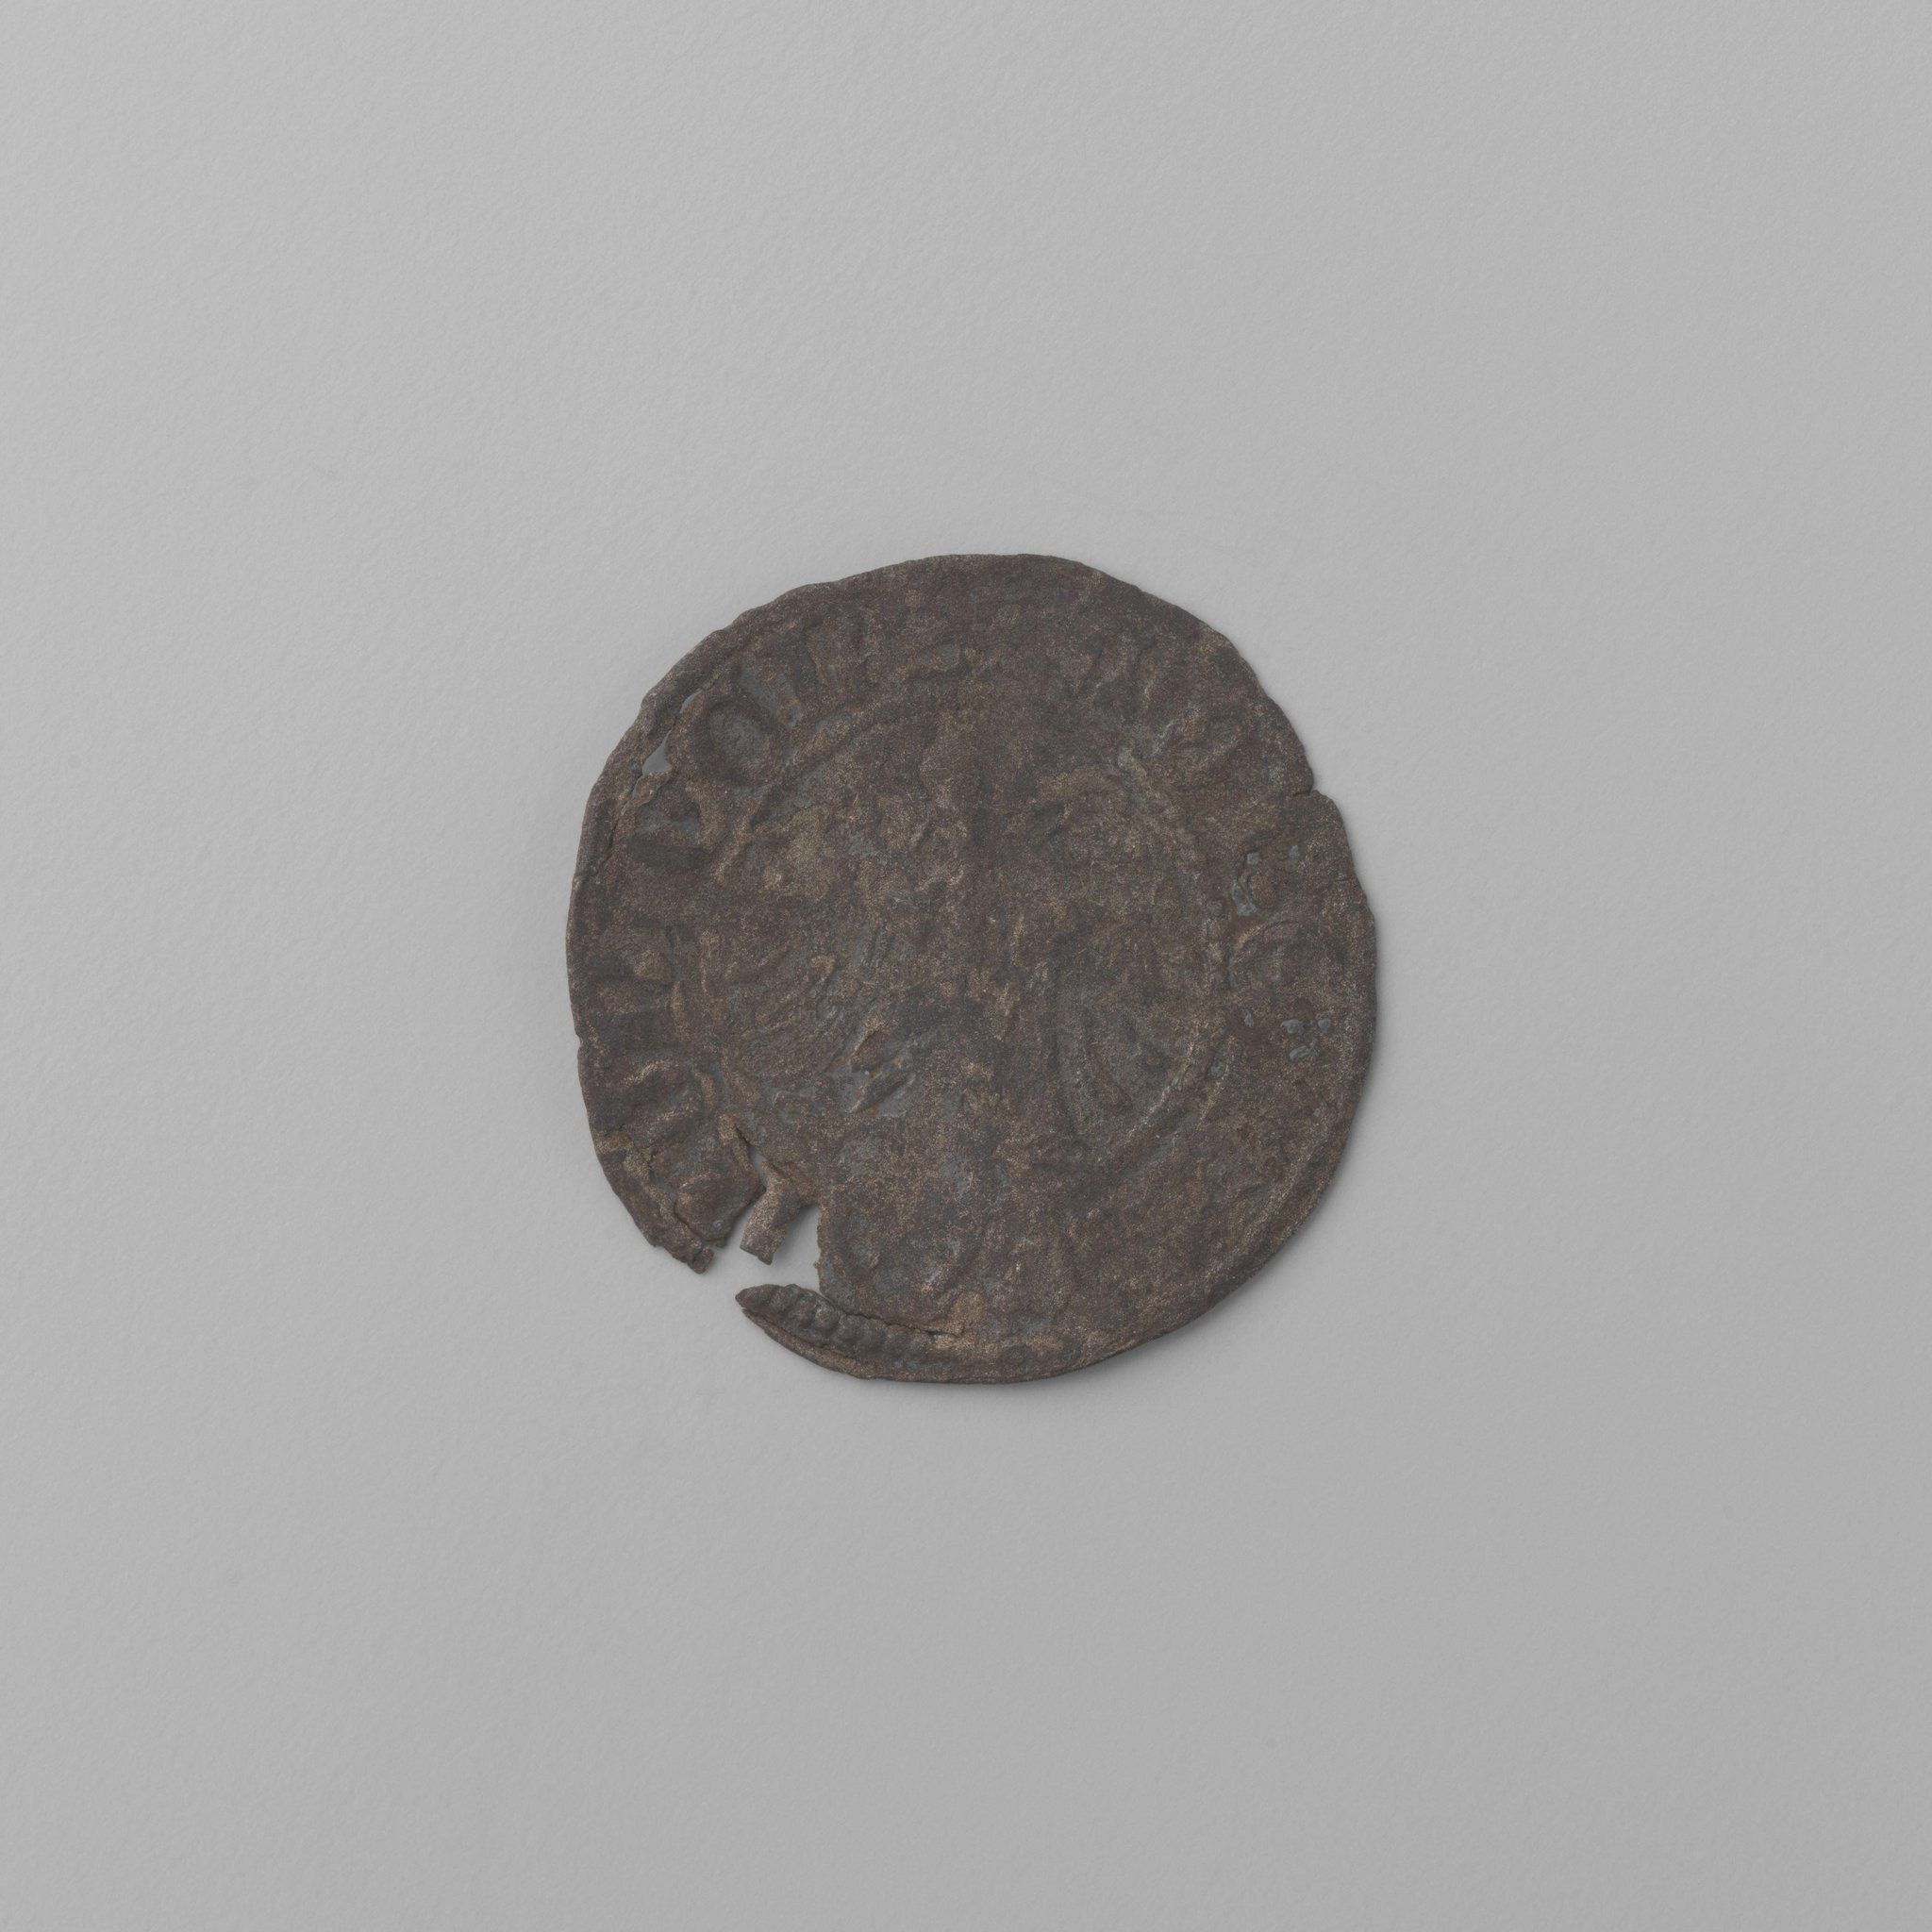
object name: coin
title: Groningse plak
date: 1425-1506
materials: silver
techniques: striking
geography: groningen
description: Zilveren munt. Voorzijde: enkelkoppige adelaar. Keerzijde: lang gevoet kruis, in het hart wapenschildje.